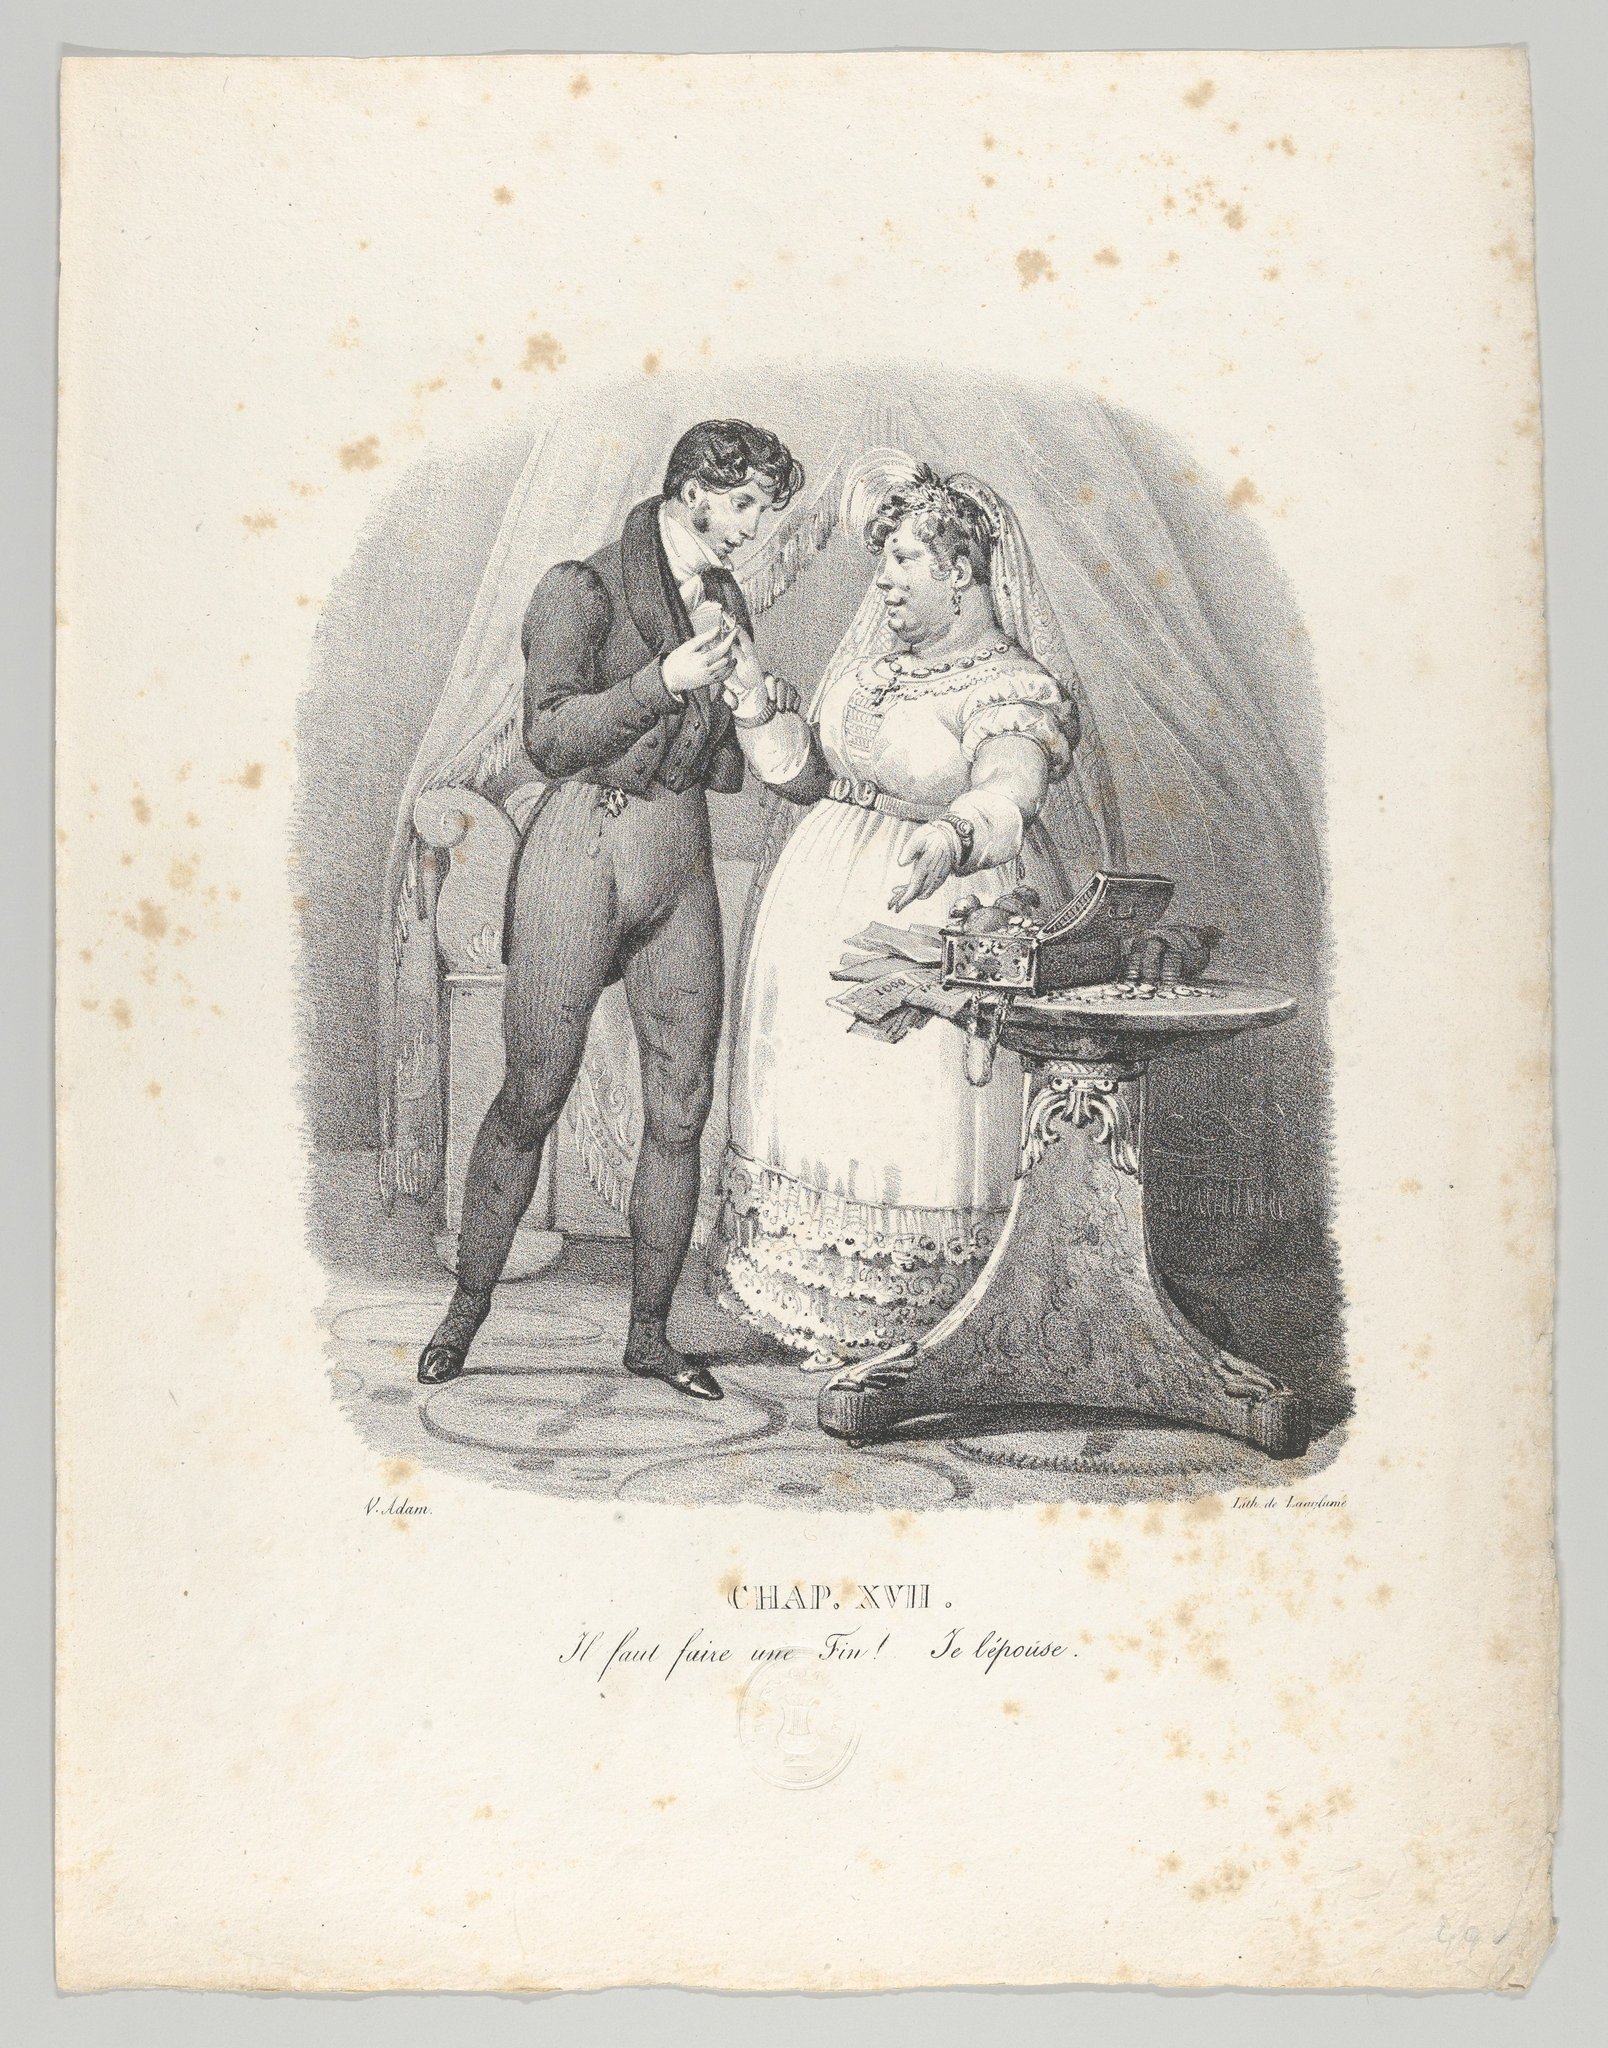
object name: print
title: Chap. XVII: Il faut faire une Fin! Je l'épouse (It must end! I am married)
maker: victor adam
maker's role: artist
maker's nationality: french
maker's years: 1801-1866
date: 1824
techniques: lithograph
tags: men,women